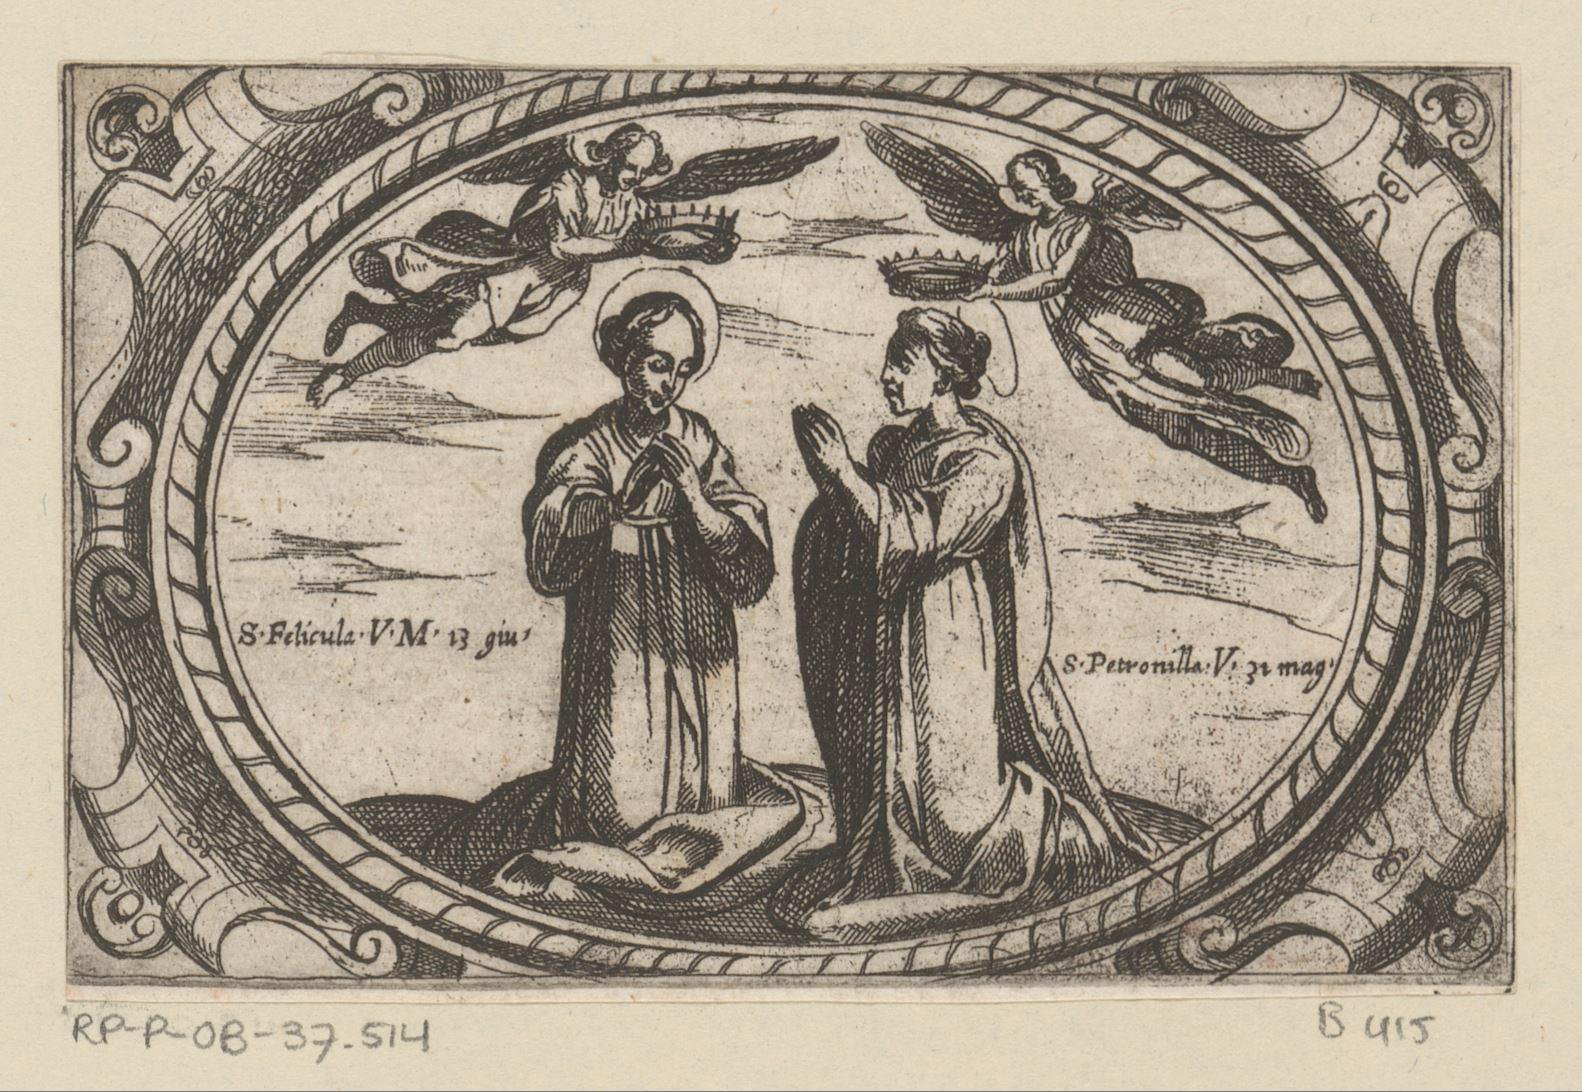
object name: print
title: Romeinse martelaressen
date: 1565-1630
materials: paper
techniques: etching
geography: rome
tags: martyr(s) (often with palm-branches) - qq - female martyr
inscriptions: collector's mark: Lugt 240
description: Deze prent maakt deel uit van een reeks van 73 prenten (+ titelprent) met voorstellingen van Romeinse martelaressen.